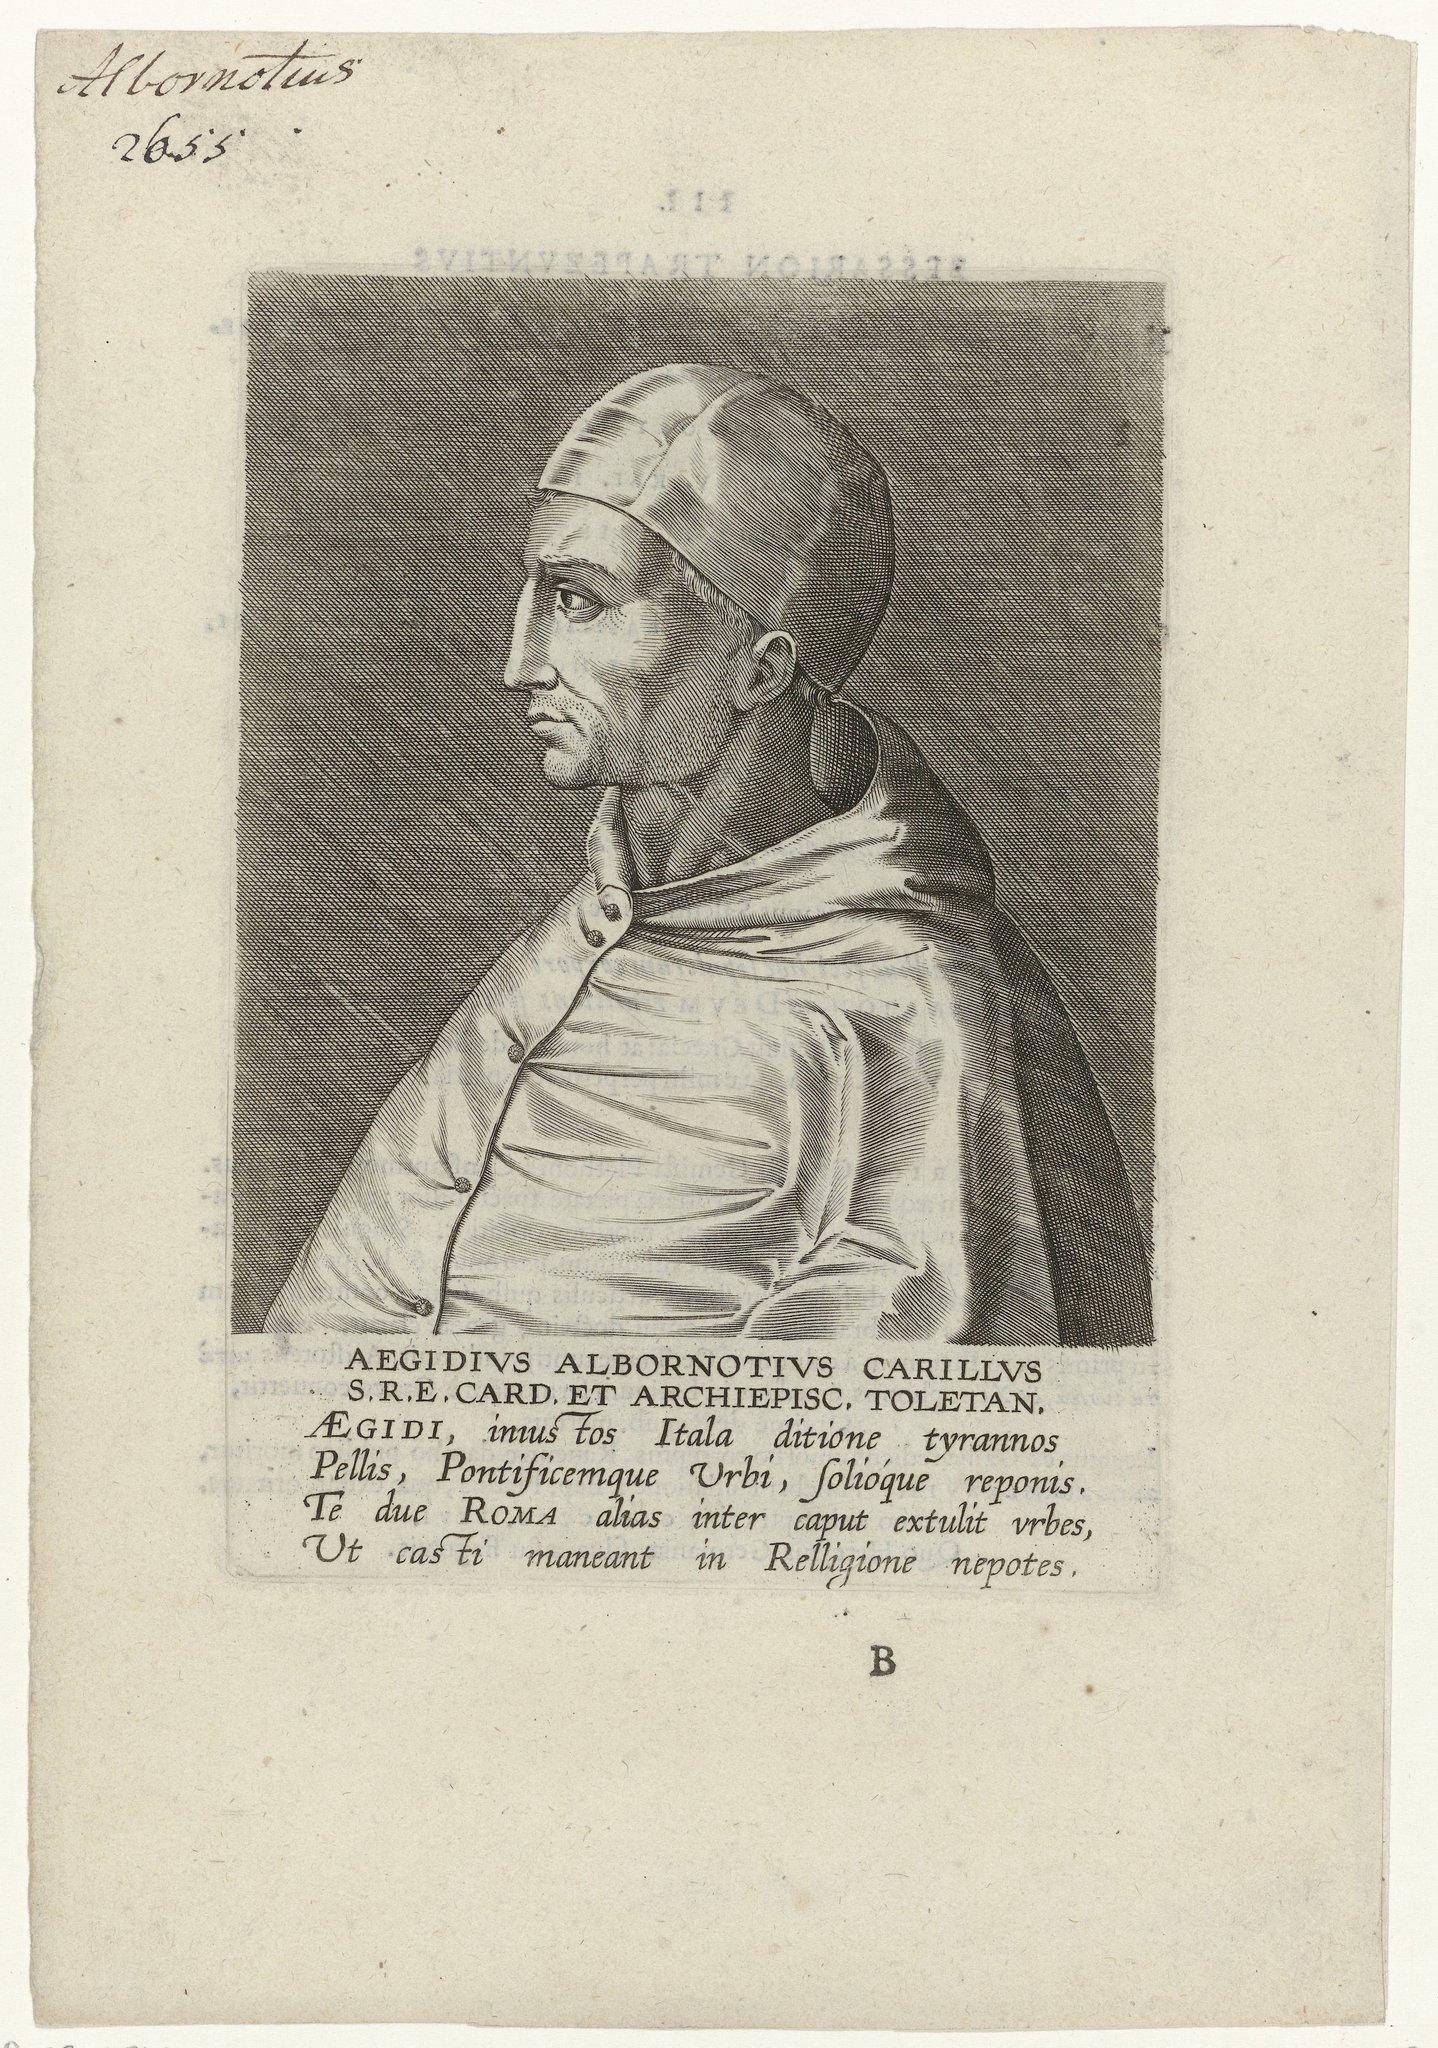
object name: print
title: Portret van kardinaal Álvarez Carrillo de Albornoz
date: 1581-1633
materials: paper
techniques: engraving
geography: antwerp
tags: kardinaal, gil álvarez carrillo de albornoz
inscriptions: inscription: ‘Albornotus 2655’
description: Portret van kardinaal Álvarez Carrillo de Albornoz. Buste naar links. De prent heeft een Latijns onderschrift. Onderaan rechts de letter B.